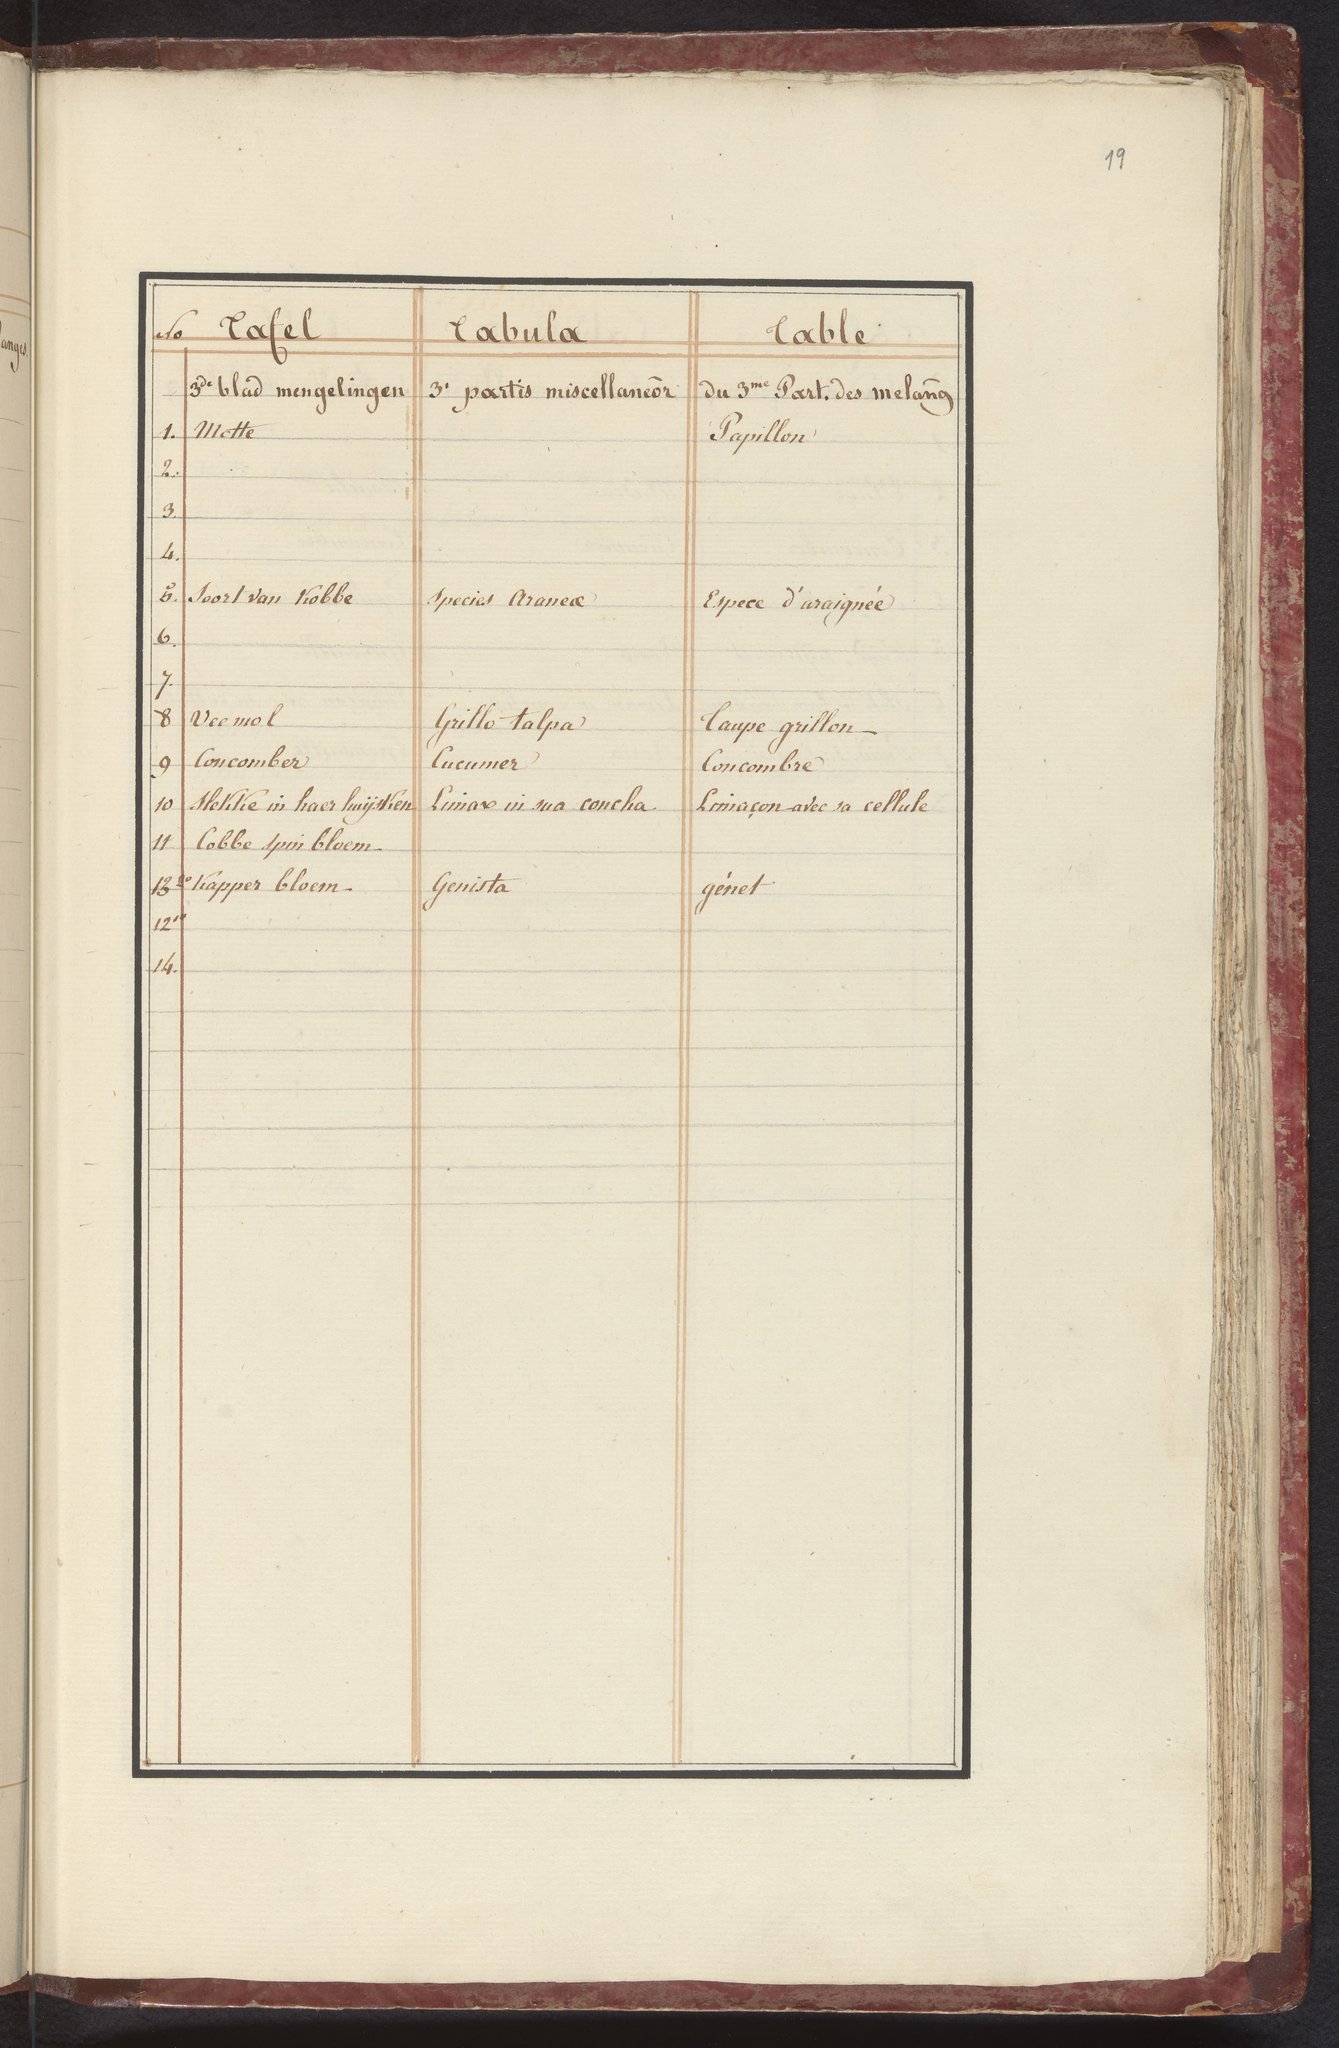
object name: manuscript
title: Lijst van dieren en planten in het derde ensemble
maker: joseph van huerne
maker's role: kunstliefhebber, mecenas, verzamelaar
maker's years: 1752-1844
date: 1809-1814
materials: ink, paper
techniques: handwriting, pen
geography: bruges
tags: handwriting, written text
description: Schema met een lijst in drie kolommen van de dieren en planten afgebeeld in het derde ensemble, nummers 1-14. Onderdeel van het zevende album met tekeningen van reptielen, amfibieën en natuurhistorische ensembles. Het zevende van twaalf albums met aquarellen van dieren, vogels en planten bekend rond 1600, gemaakt in opdracht van keizer Rudolf II. Met toelichting in Nederlands, Latijn en Frans.